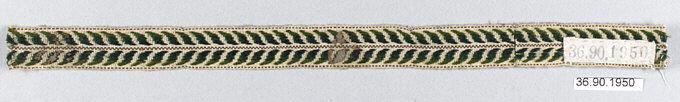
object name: galloon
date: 1767-1833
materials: silk